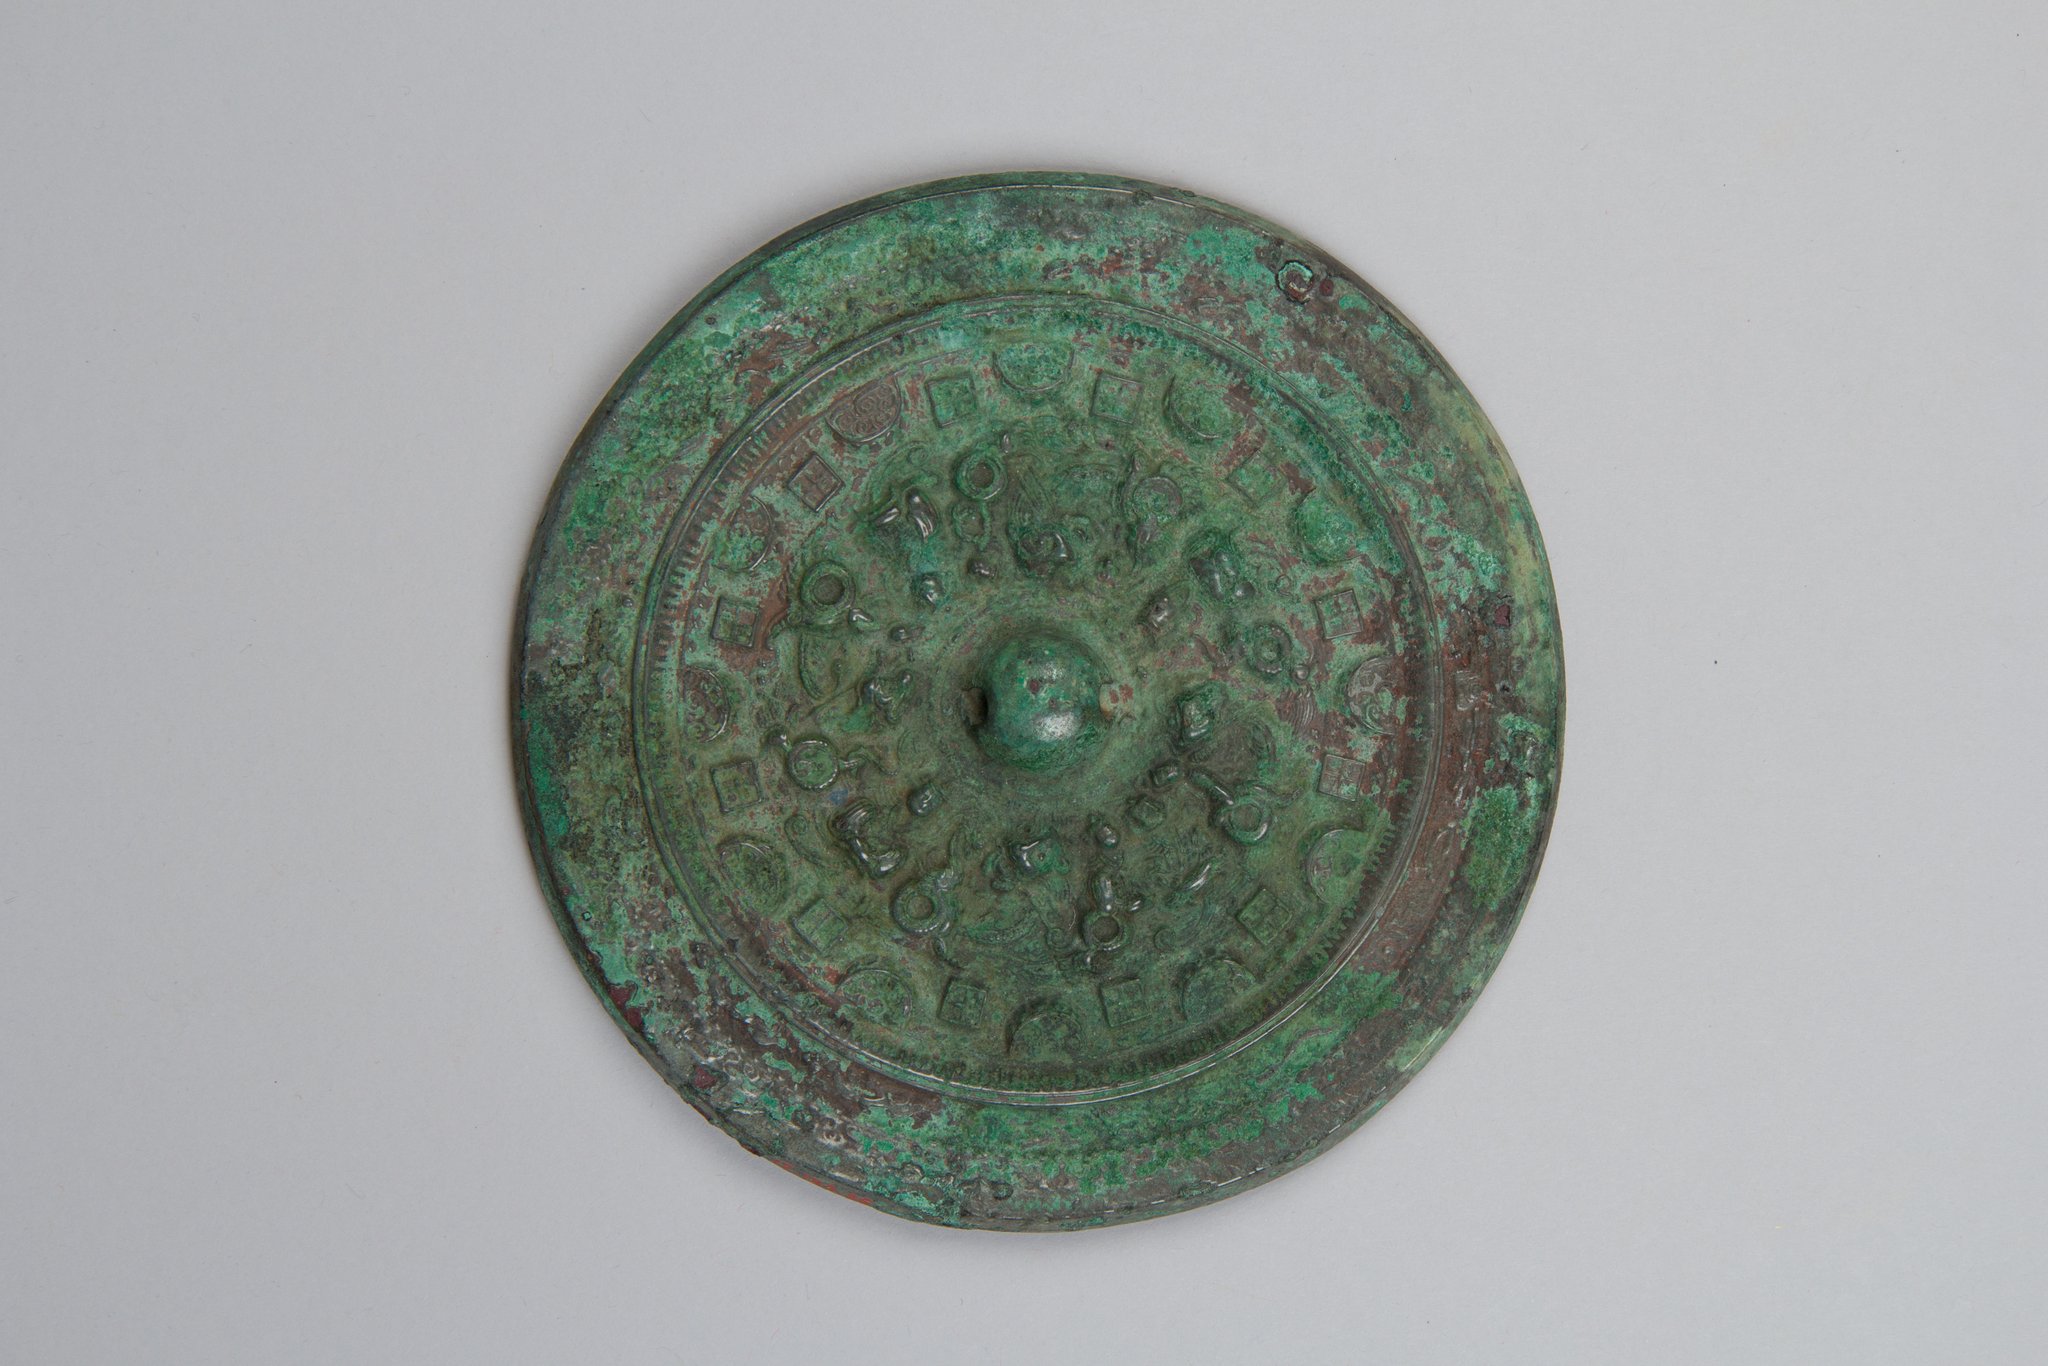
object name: mirror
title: Mirror with deities and mythical creatures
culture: chinese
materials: bronze, patina